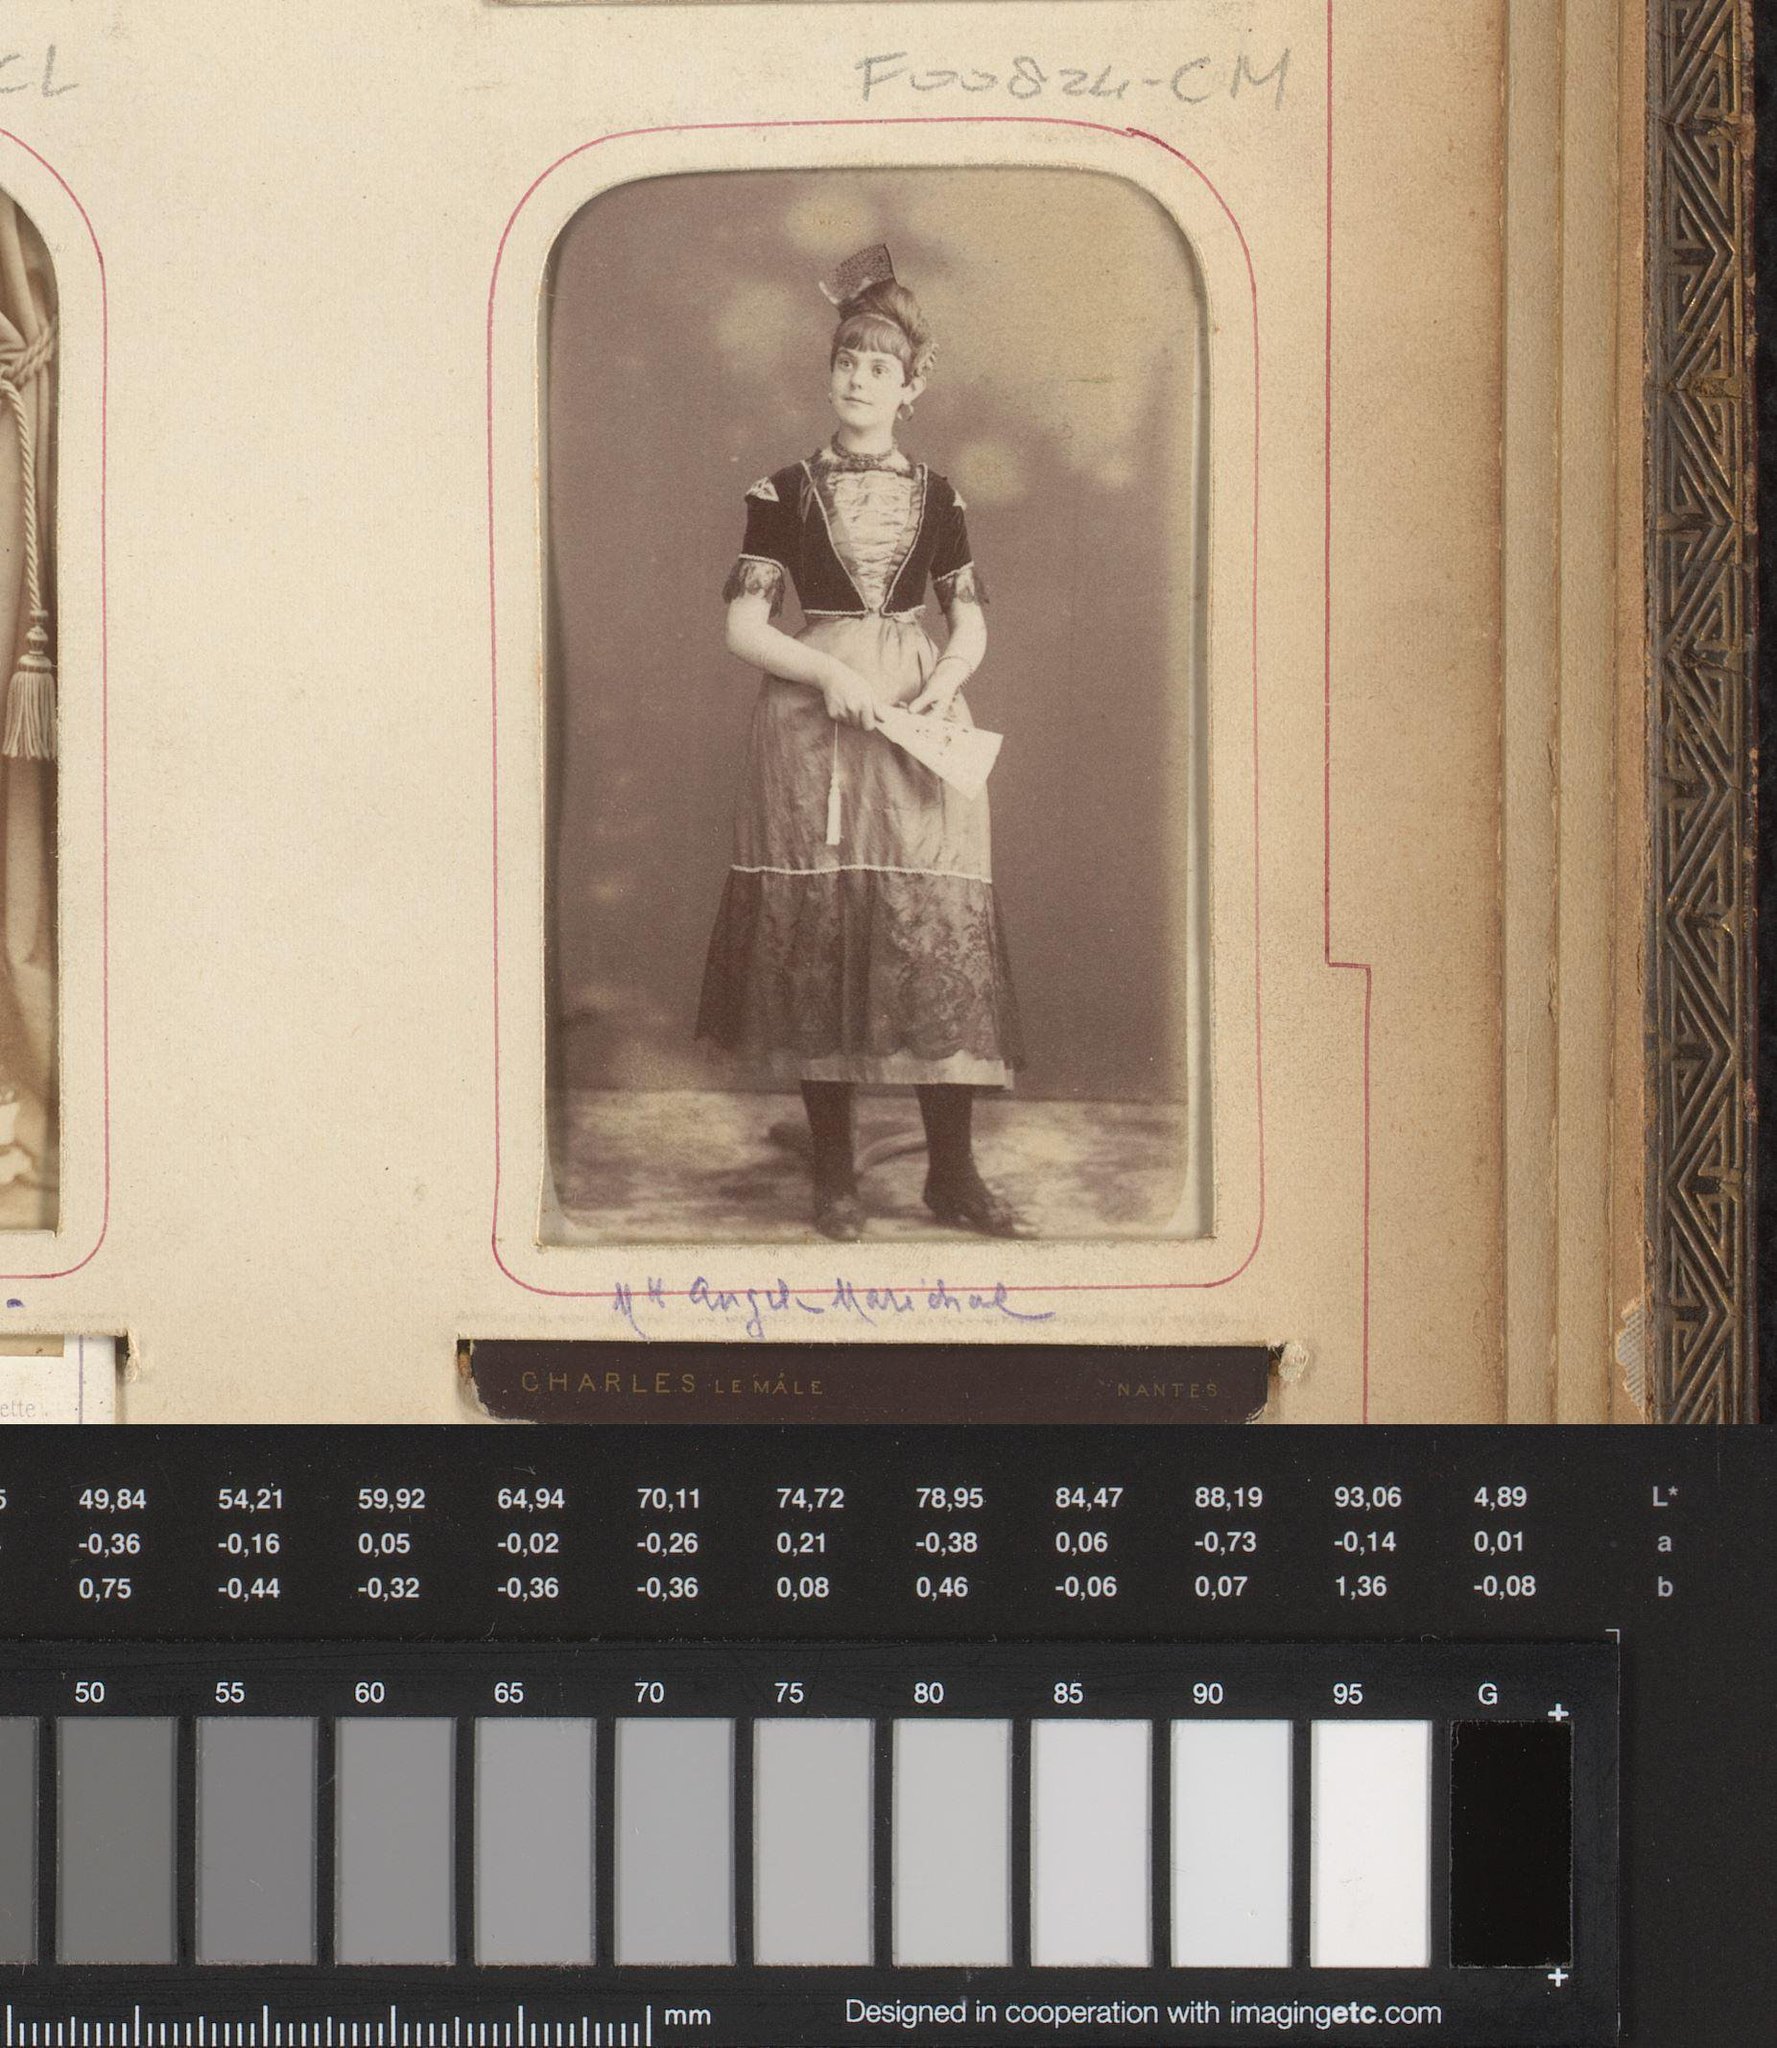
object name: album leaf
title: Portret van Angele Maréchal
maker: charles lemâle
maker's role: fotograaf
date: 1854-1885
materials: cardboard, celluloid, paper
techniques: albumen print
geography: nantes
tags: adolescent, young woman, maiden, historical persons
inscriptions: inscription: ‘On conserve les Clichés/ D. HUTINET, PARIS.’, address: ‘8, Rue du Chapeau Rouge, 8./ CONTIGUË A L'ANCIENNE POSTE/ NANTES’